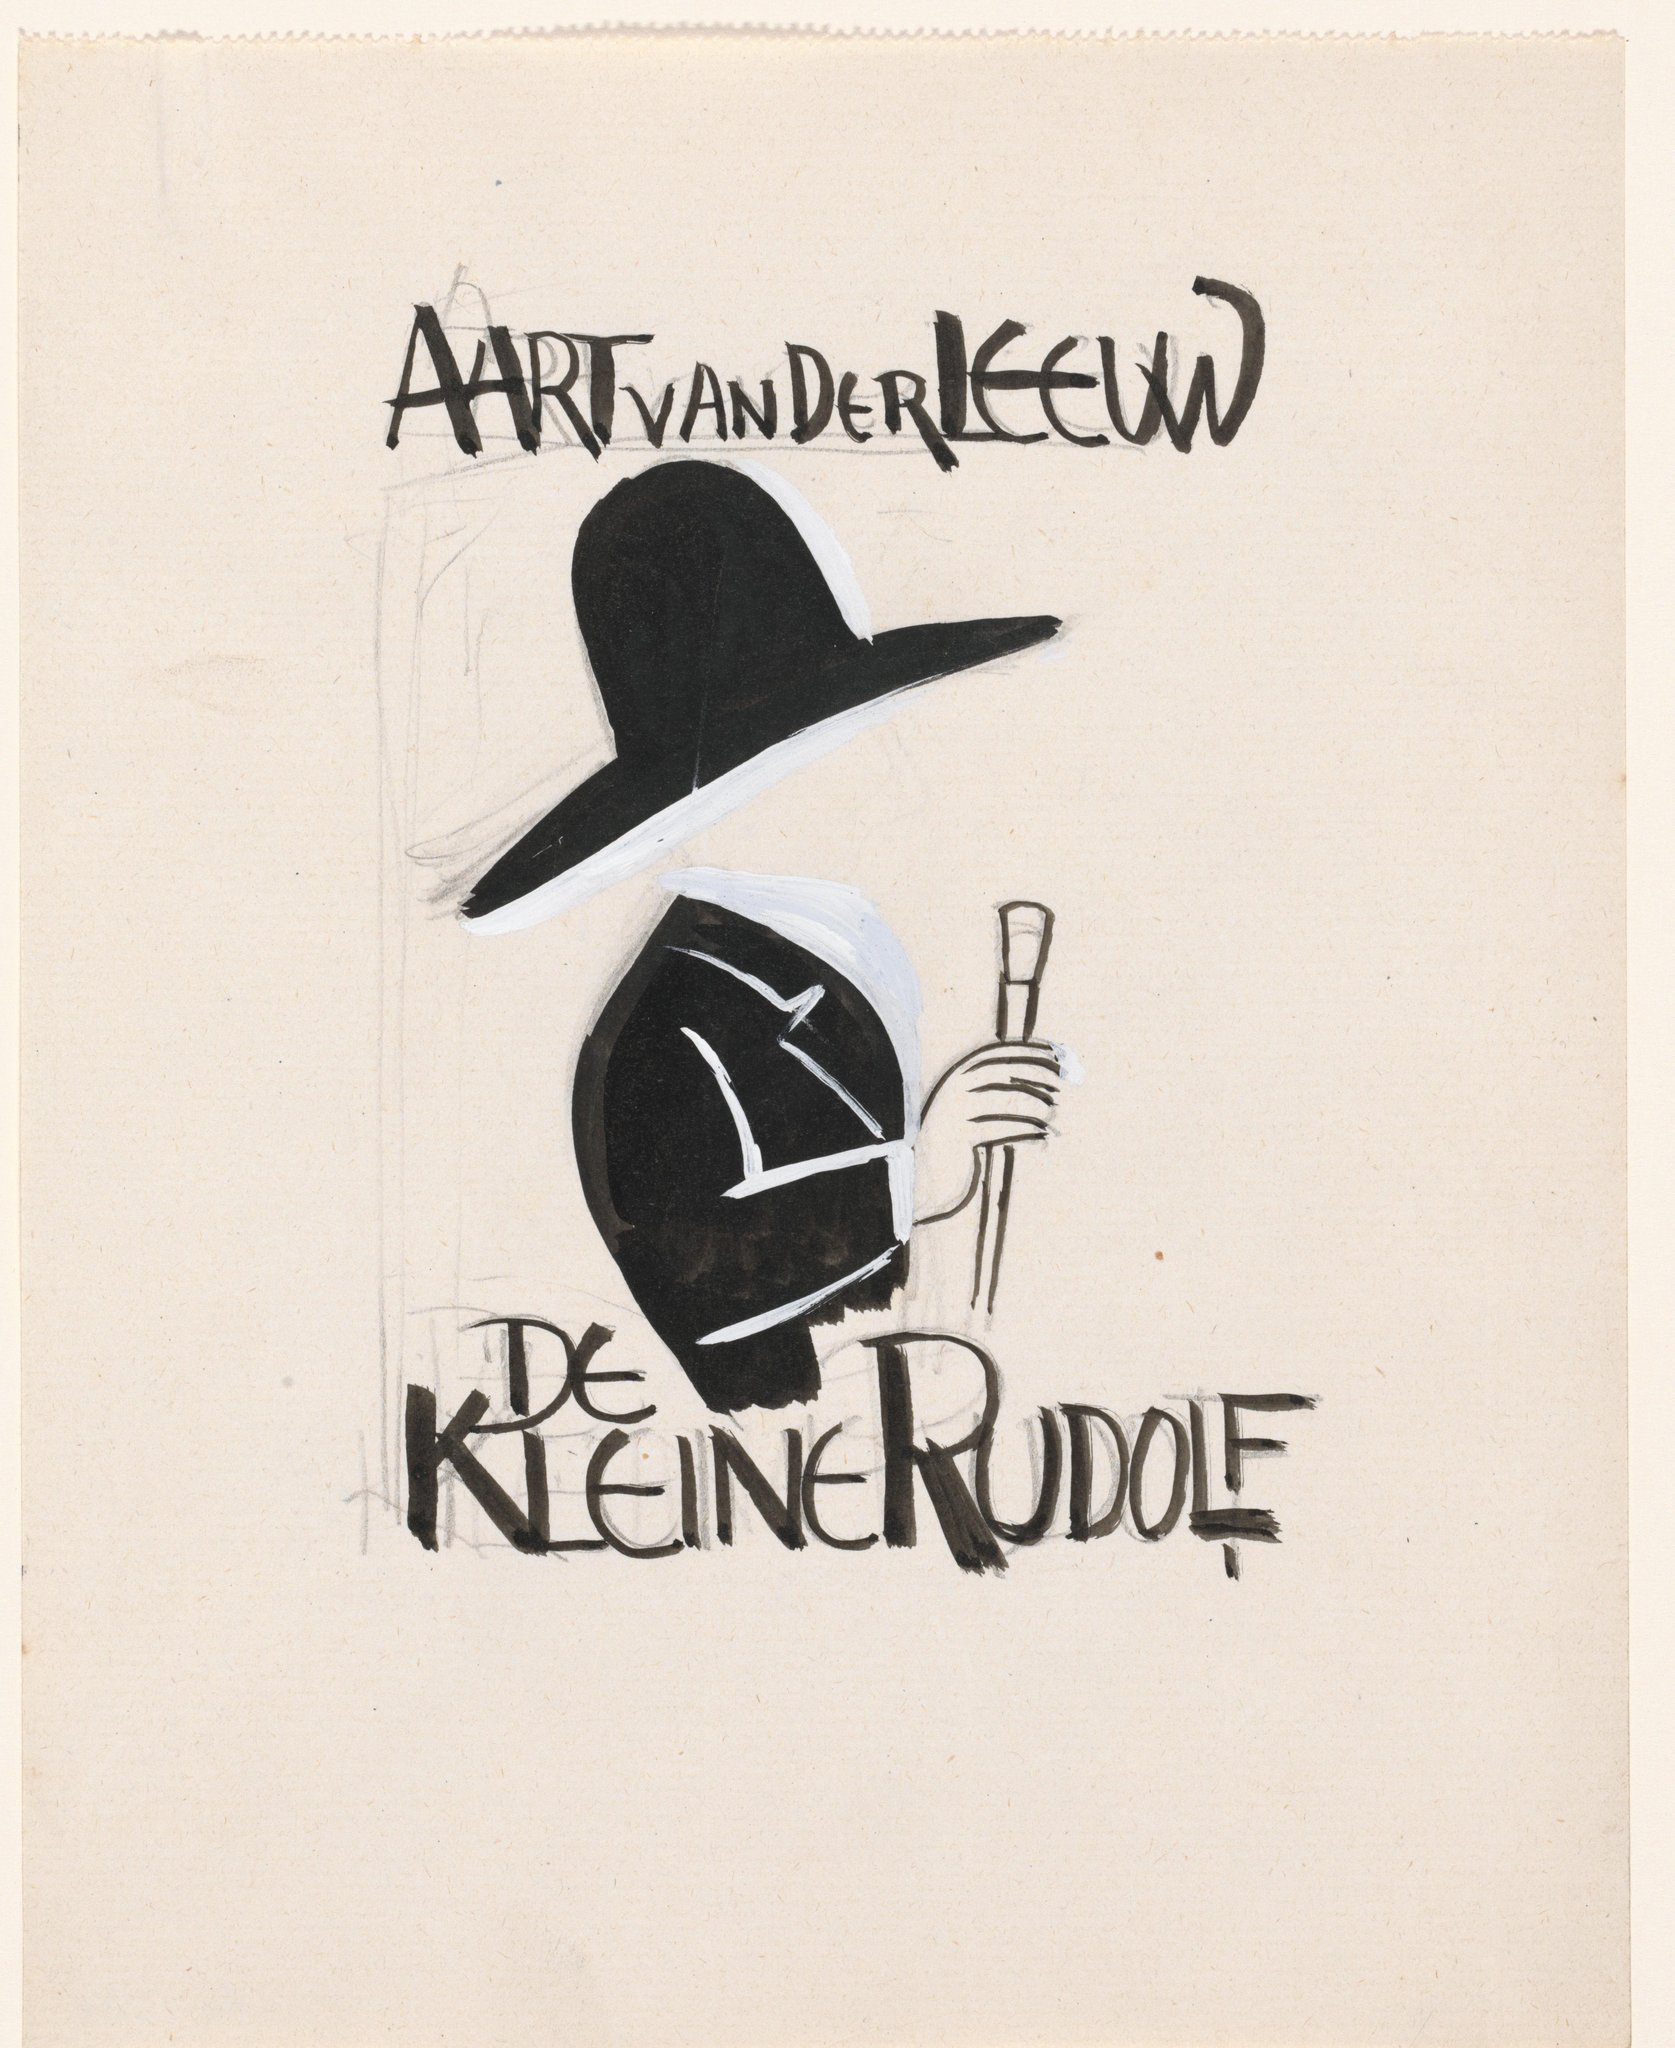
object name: study for binding design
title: Ontwerp voor een boekband voor: Aart van der Leeuw, De kleine Rudolf, 1930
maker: leo gestel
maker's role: draughtsman, print maker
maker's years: 1881-1941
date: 1928-1930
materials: paint, paper, pencil, watercolor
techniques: brush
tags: (leeuw, de kleine rudolf) specific works of literature (with author, title), boy (child between toddler and youth), head-gear: hat (+ men's clothes)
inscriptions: : Lugt 2228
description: Ontwerp voor een boekband voor: Leeuw, Aart van der. De kleine Rudolf. Amsterdam: Nijgh & Van Ditmar, 1930.